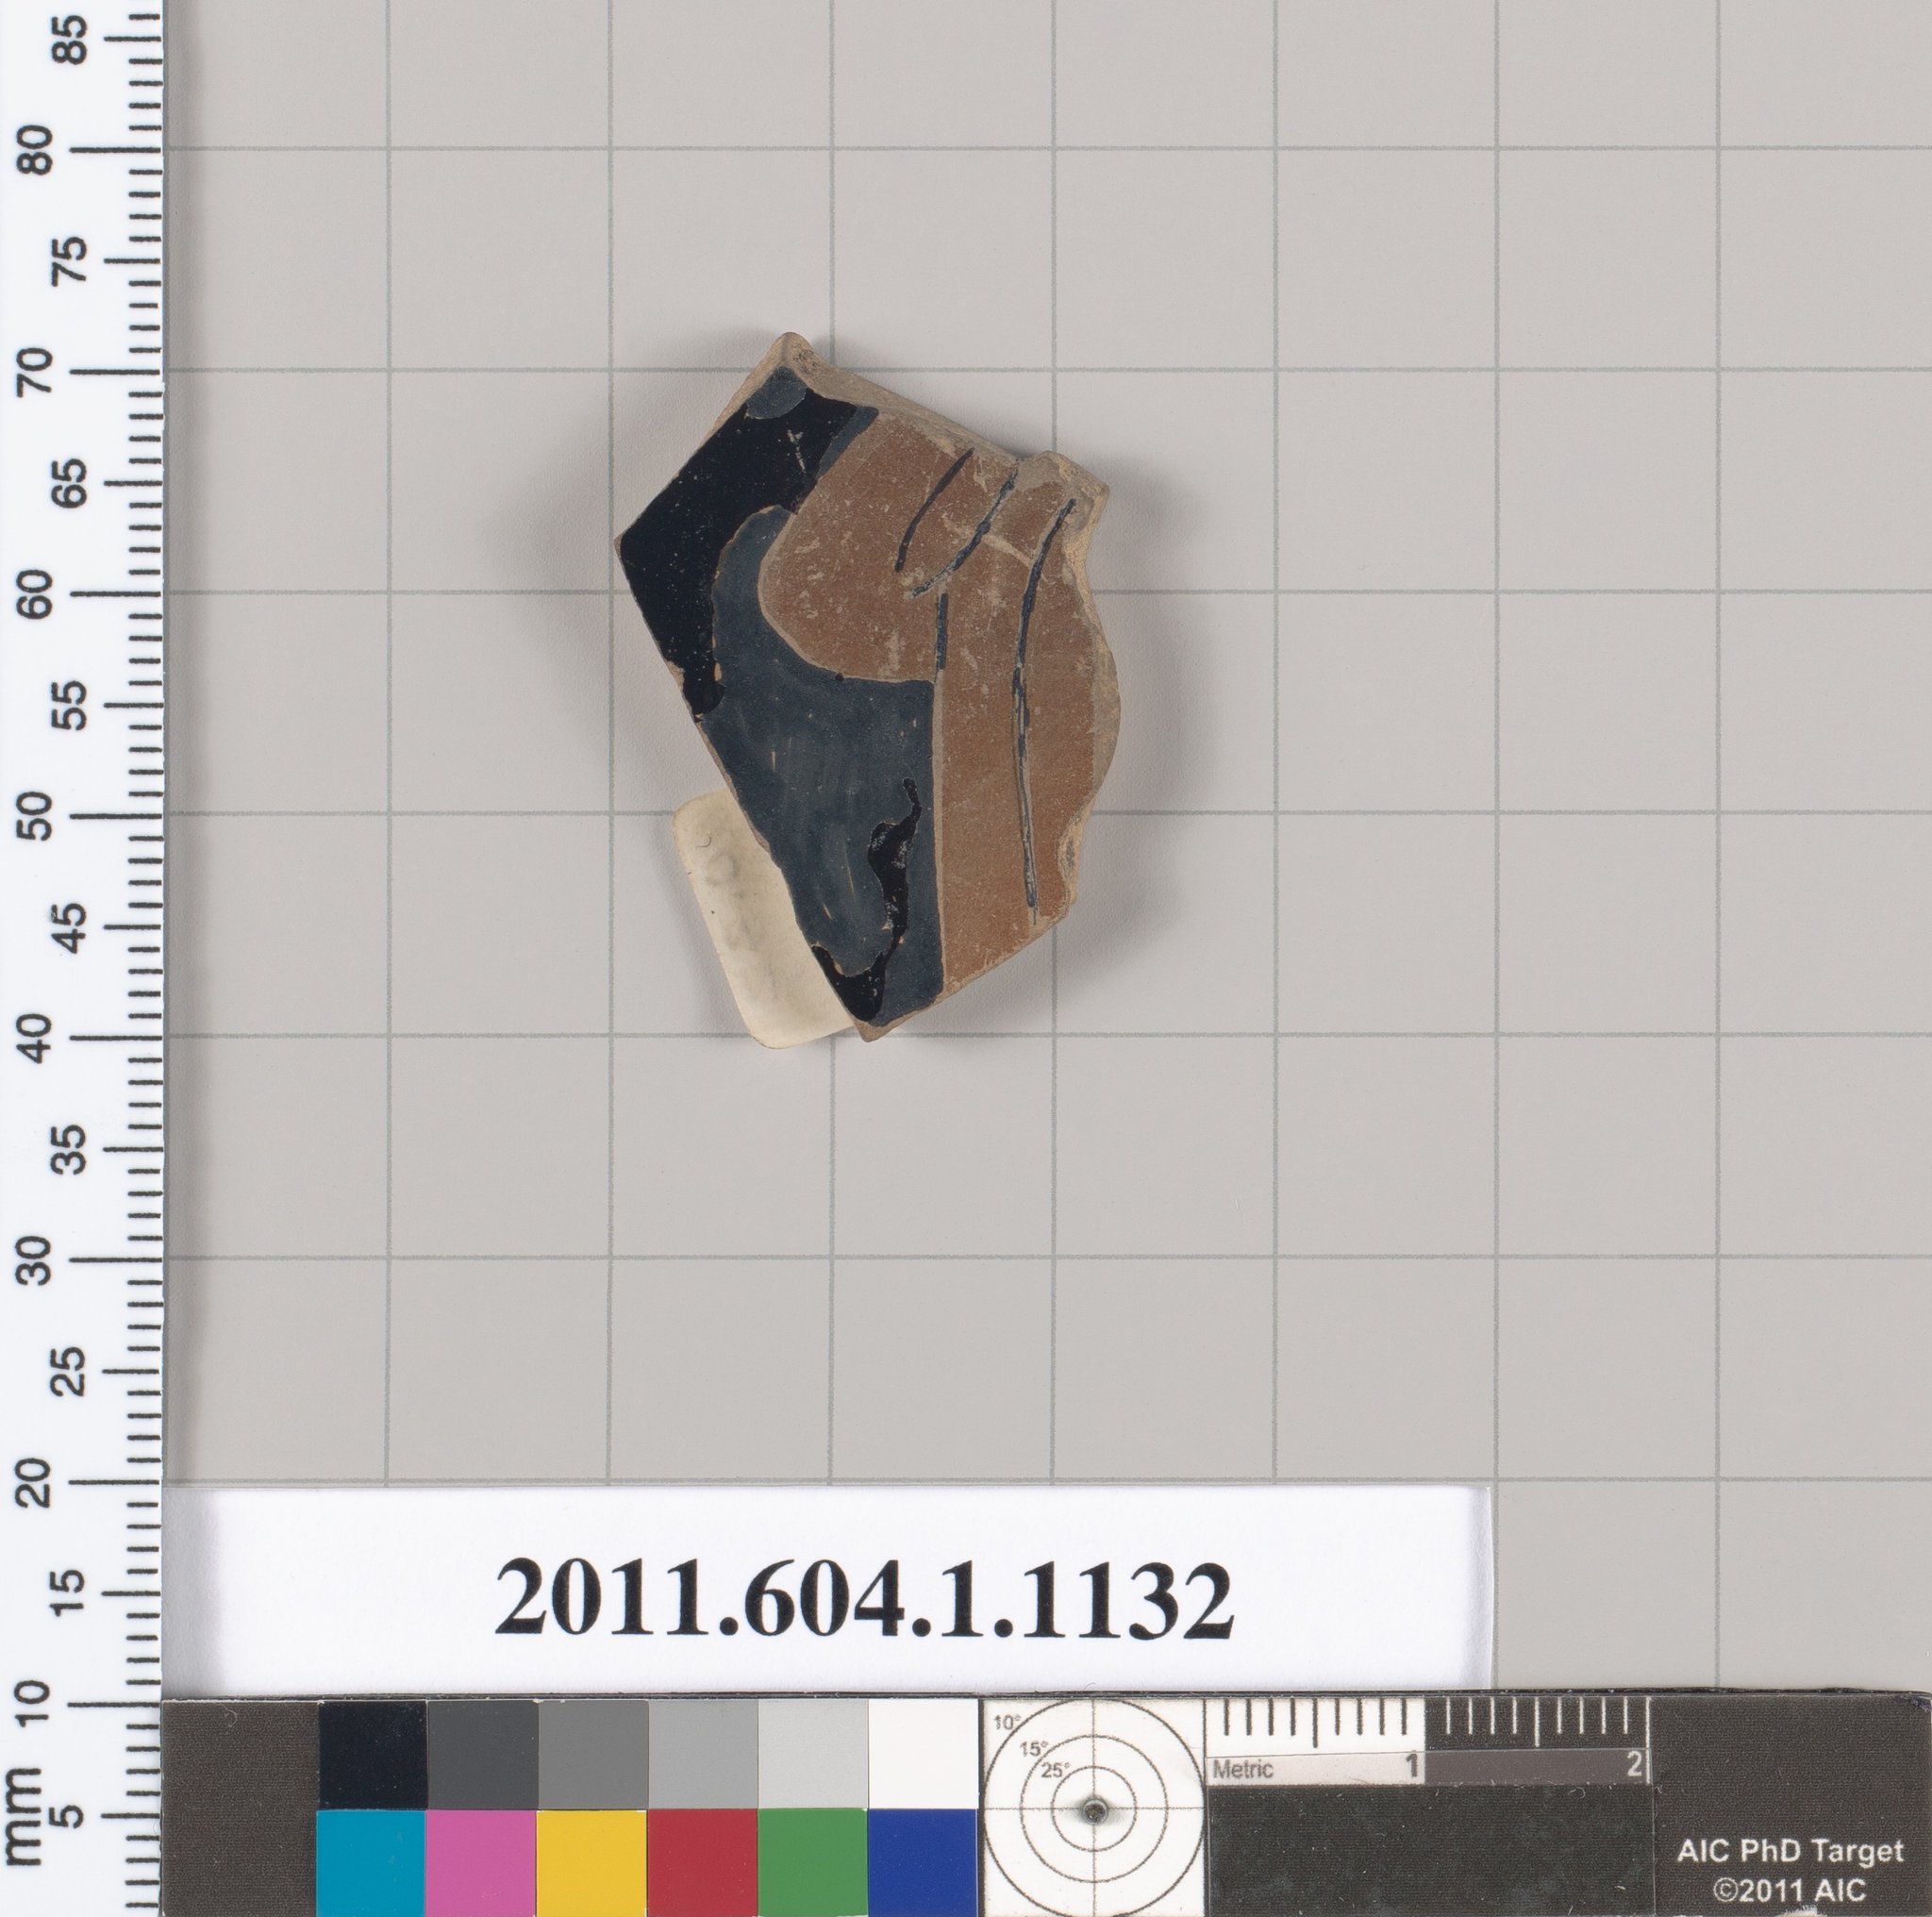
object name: kylix fragment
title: Terracotta fragment of a kylix (drinking cup)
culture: greek, attic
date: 475-451 BCE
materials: terracotta